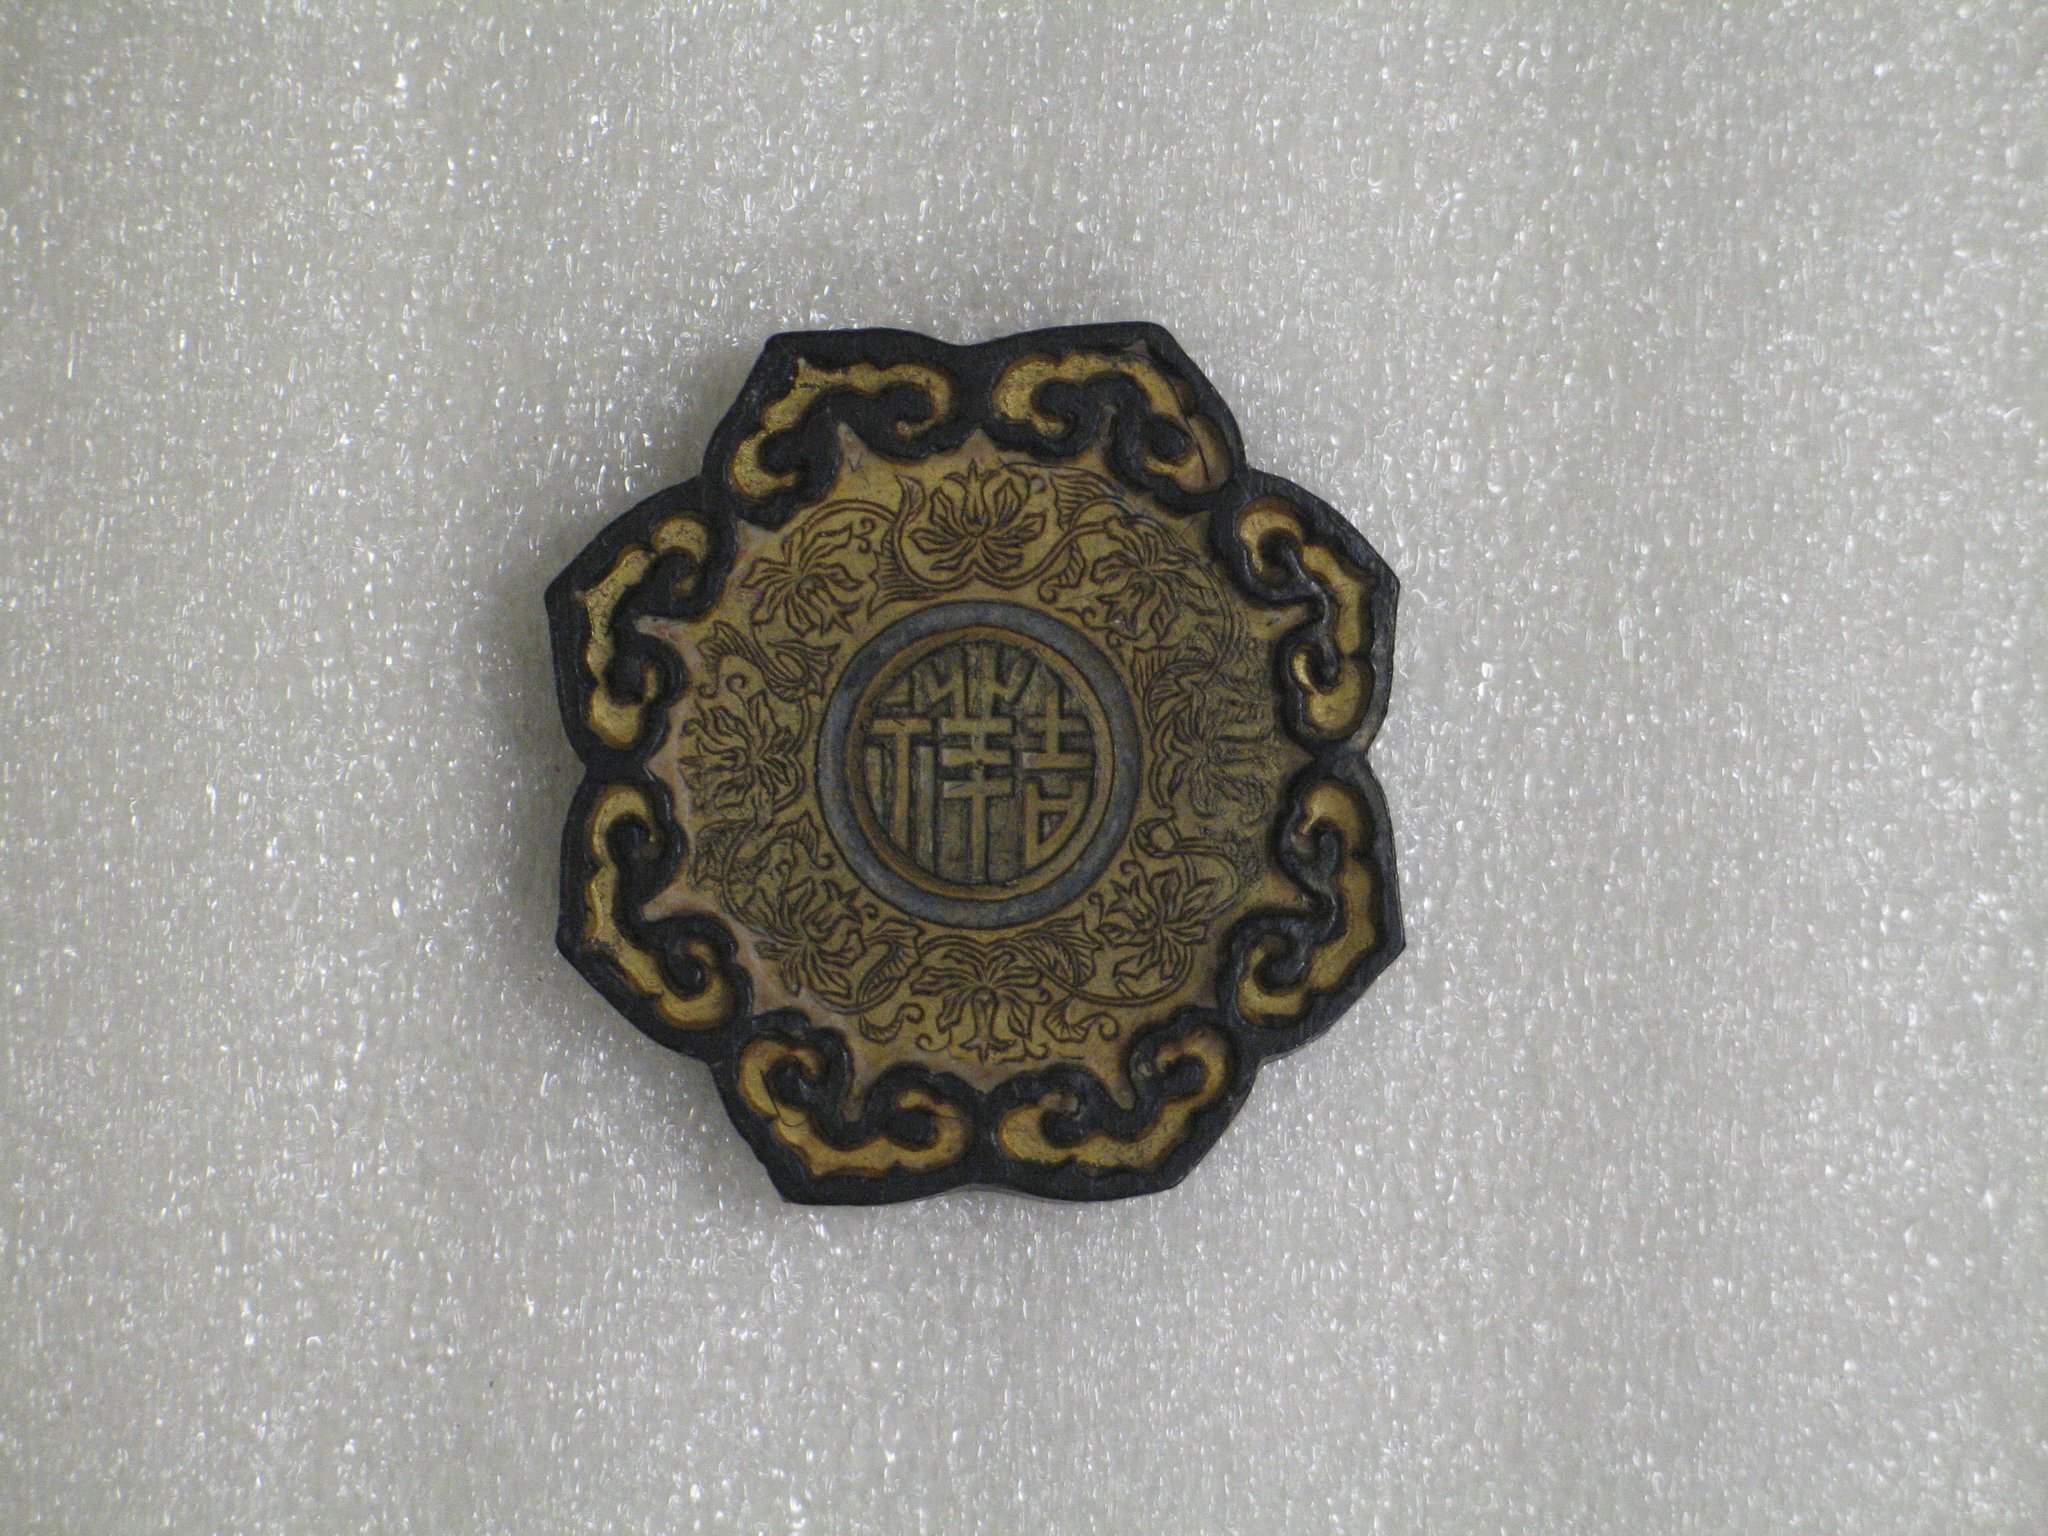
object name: ink tablet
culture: chinese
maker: xiu fangzhai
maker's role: artist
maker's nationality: chinese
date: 1662-1722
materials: ink